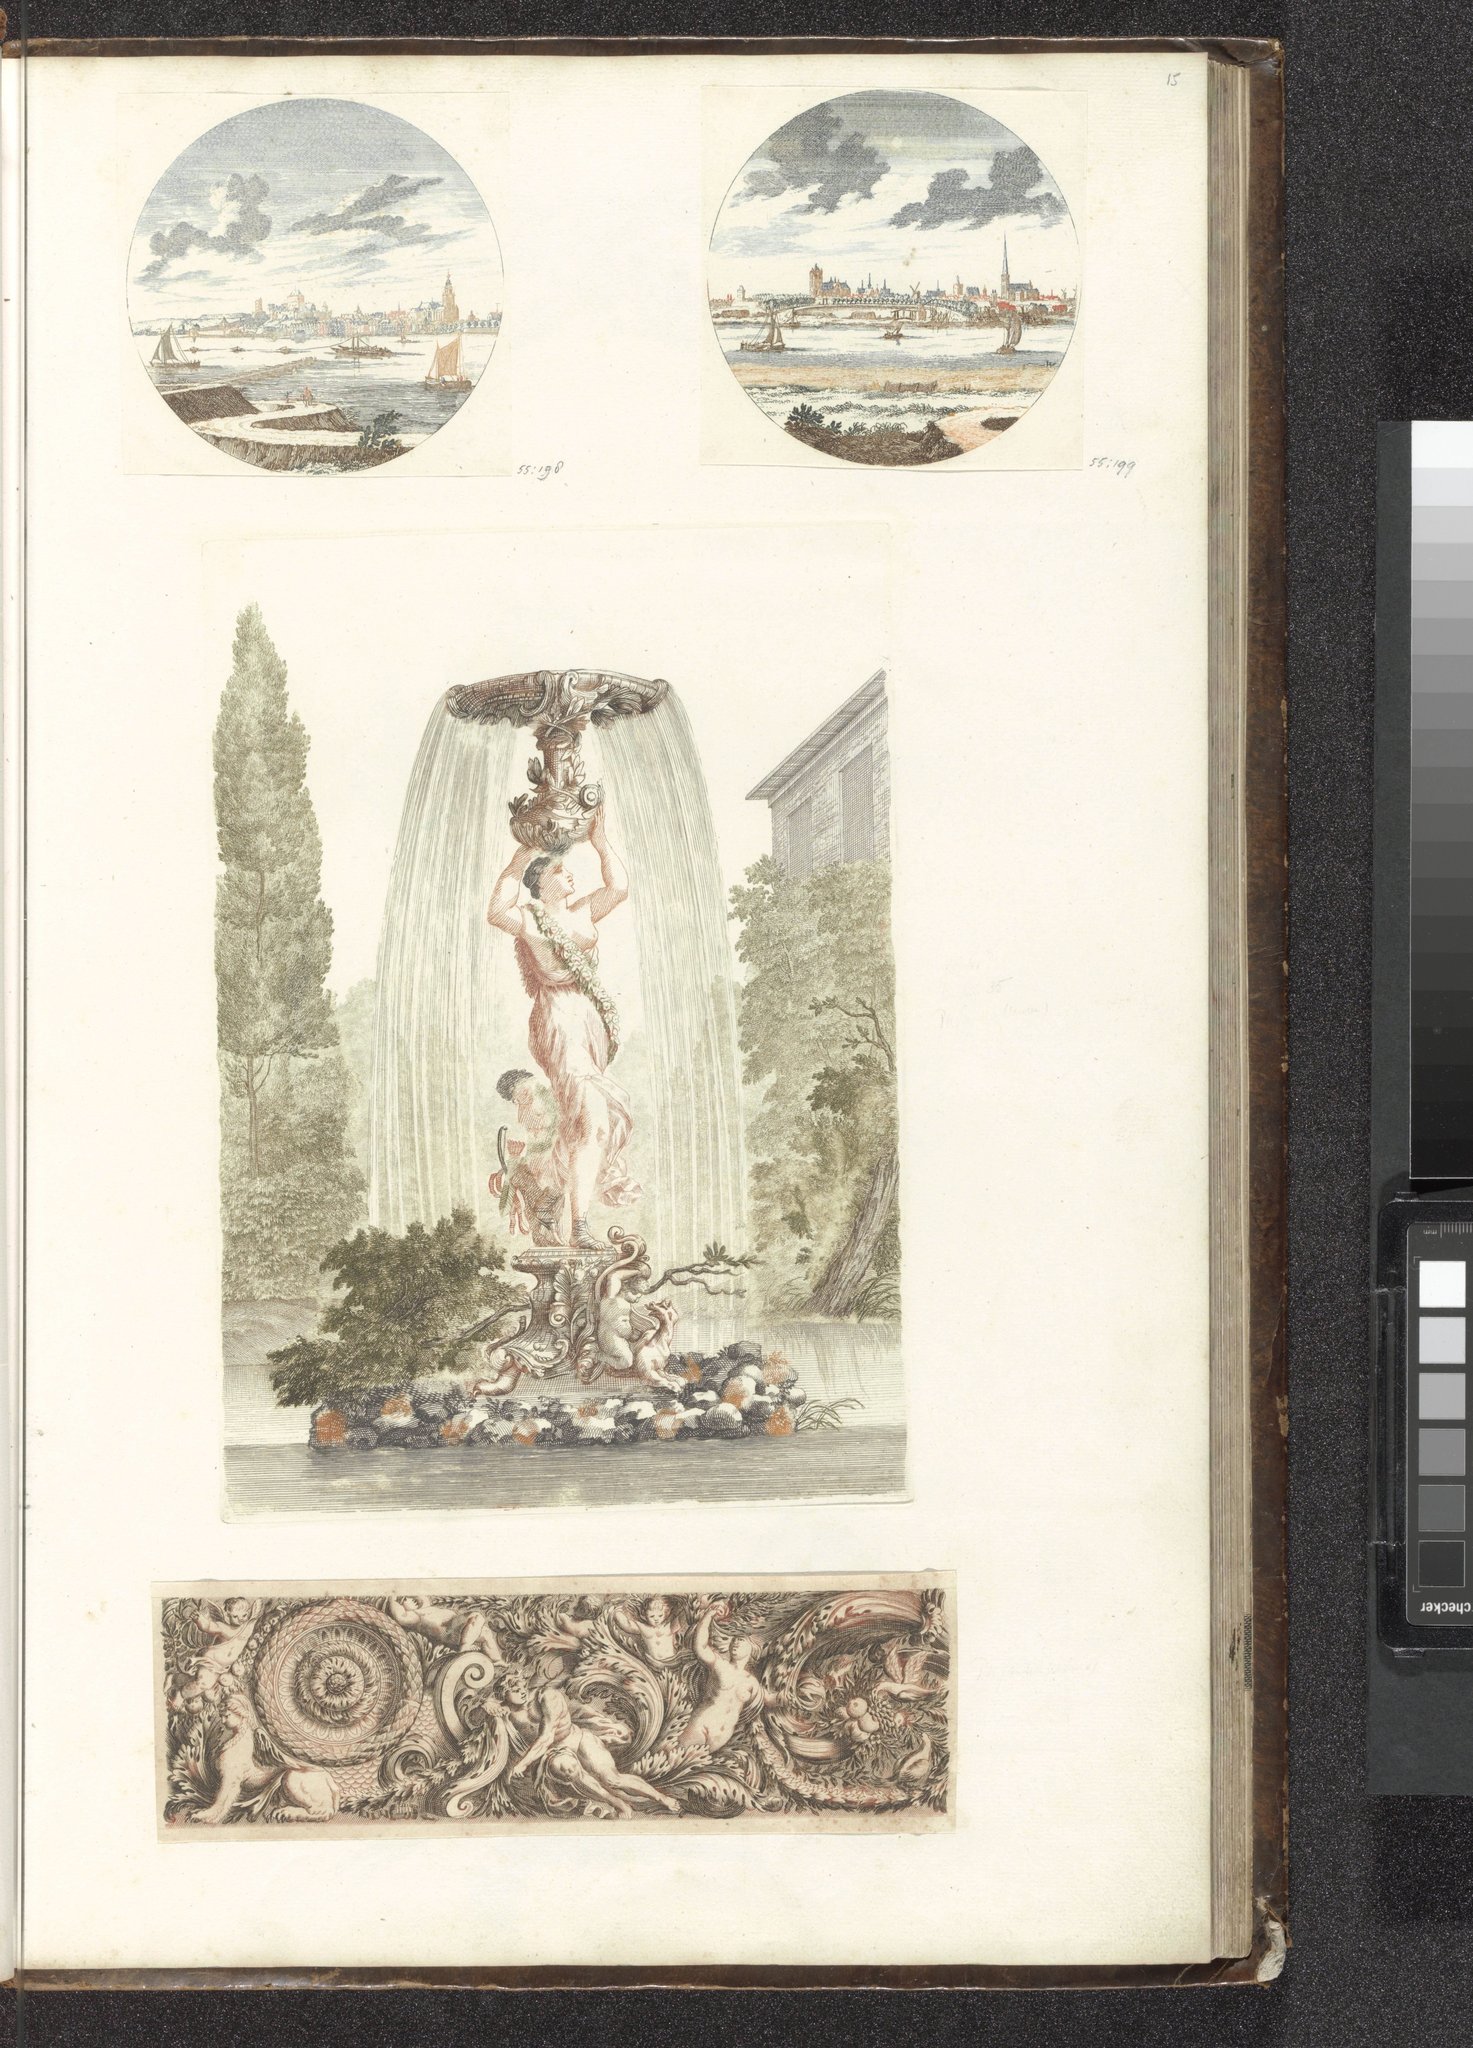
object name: print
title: Gezicht op Nijmegen vanuit het noorden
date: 1688-1698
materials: paper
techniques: etching, lithography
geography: netherlands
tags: river, nijmegen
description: Gezicht op de stad Nijmegen vanuit het noorden. Op de voorgrond de rivier met zeilschepen. Deze prent maakt deel uit van een album.